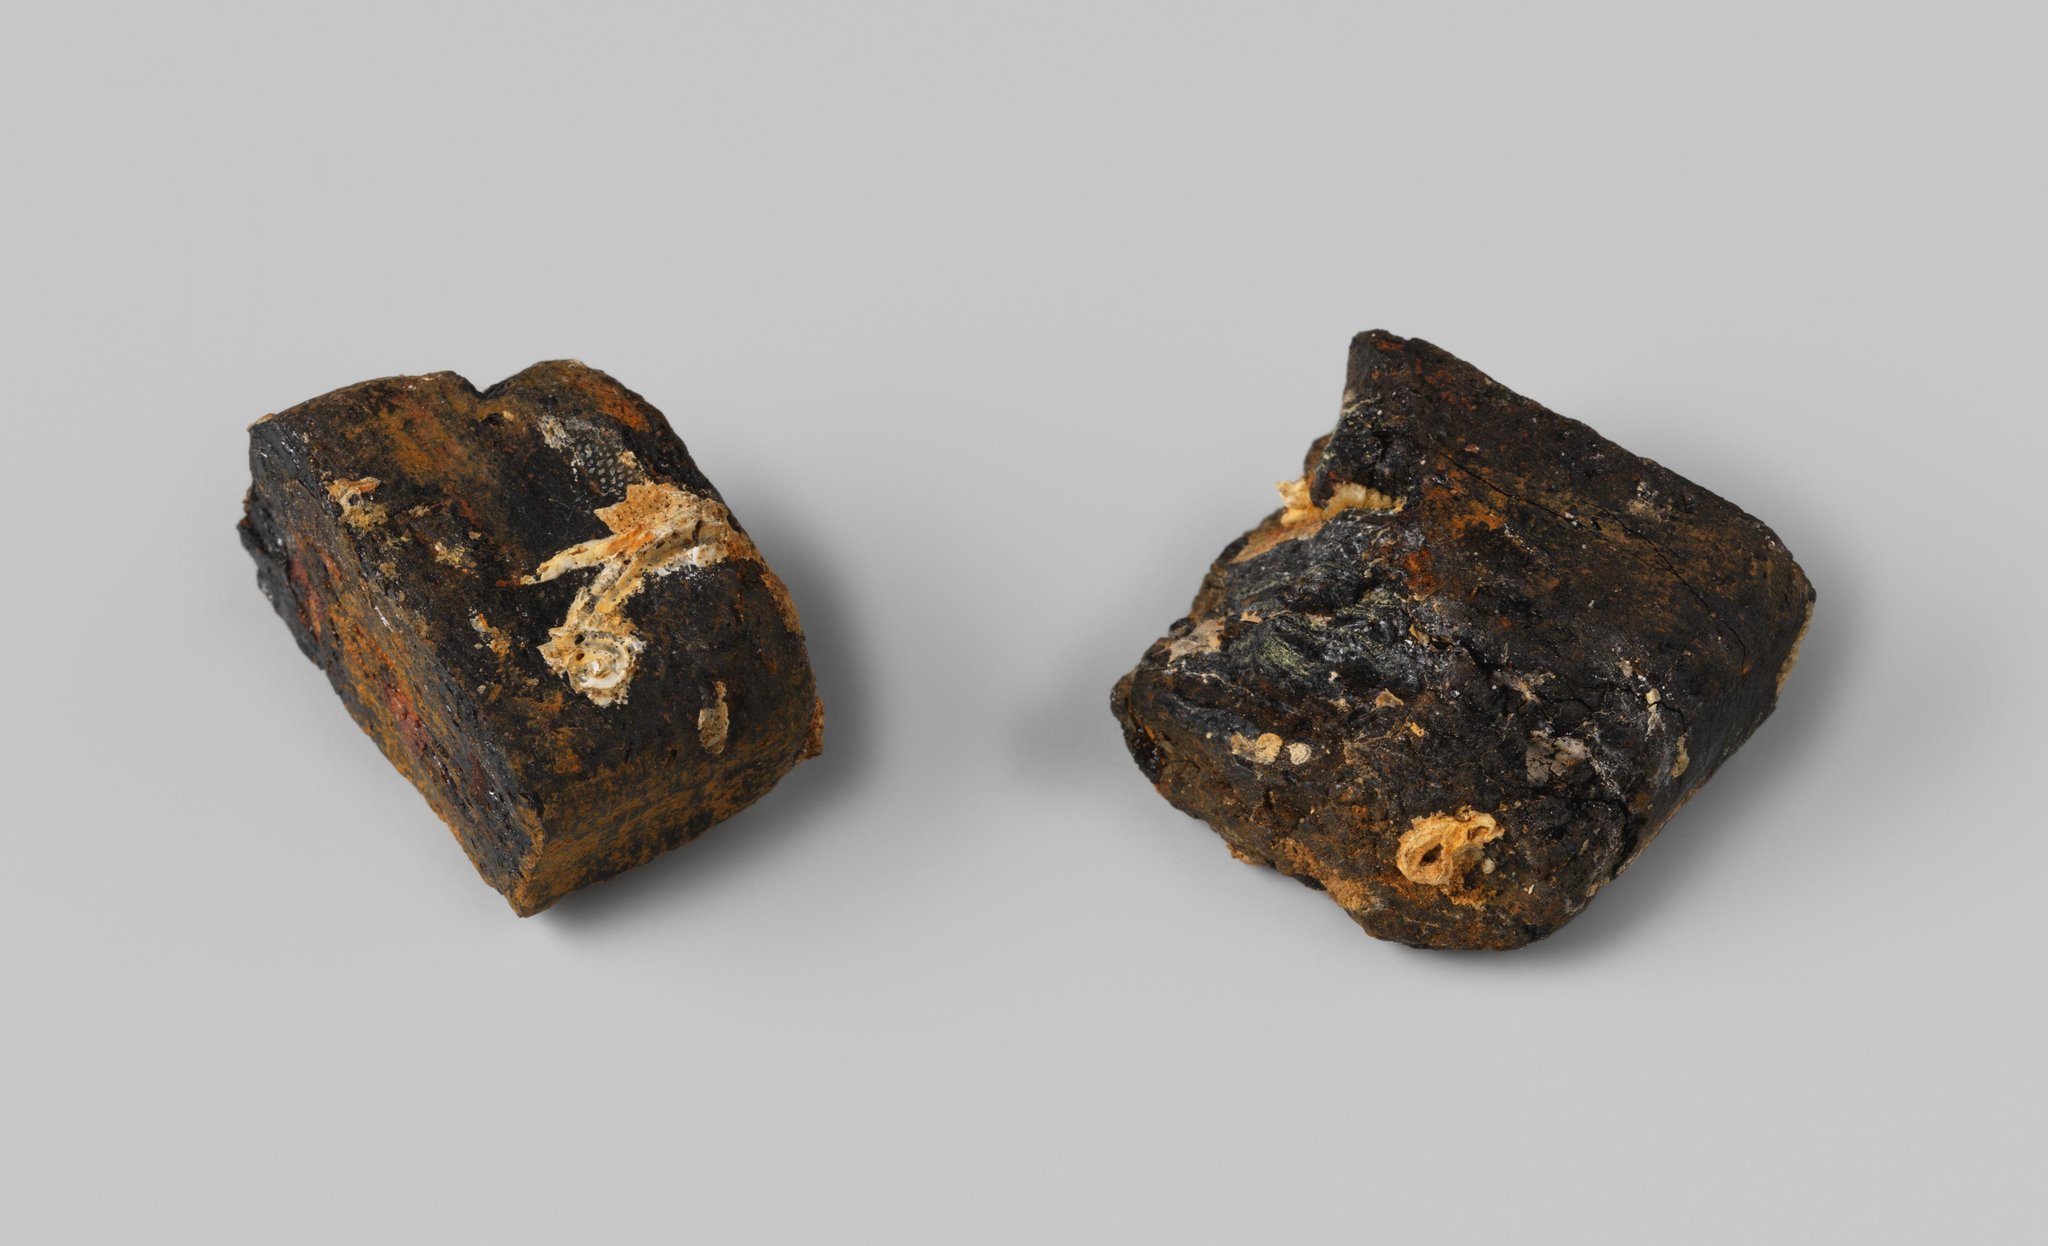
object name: charcoal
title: Houtskool uit het wrak van de Oostindiëvaarder Hollandia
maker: Anonymous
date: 1700-1743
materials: charcoal